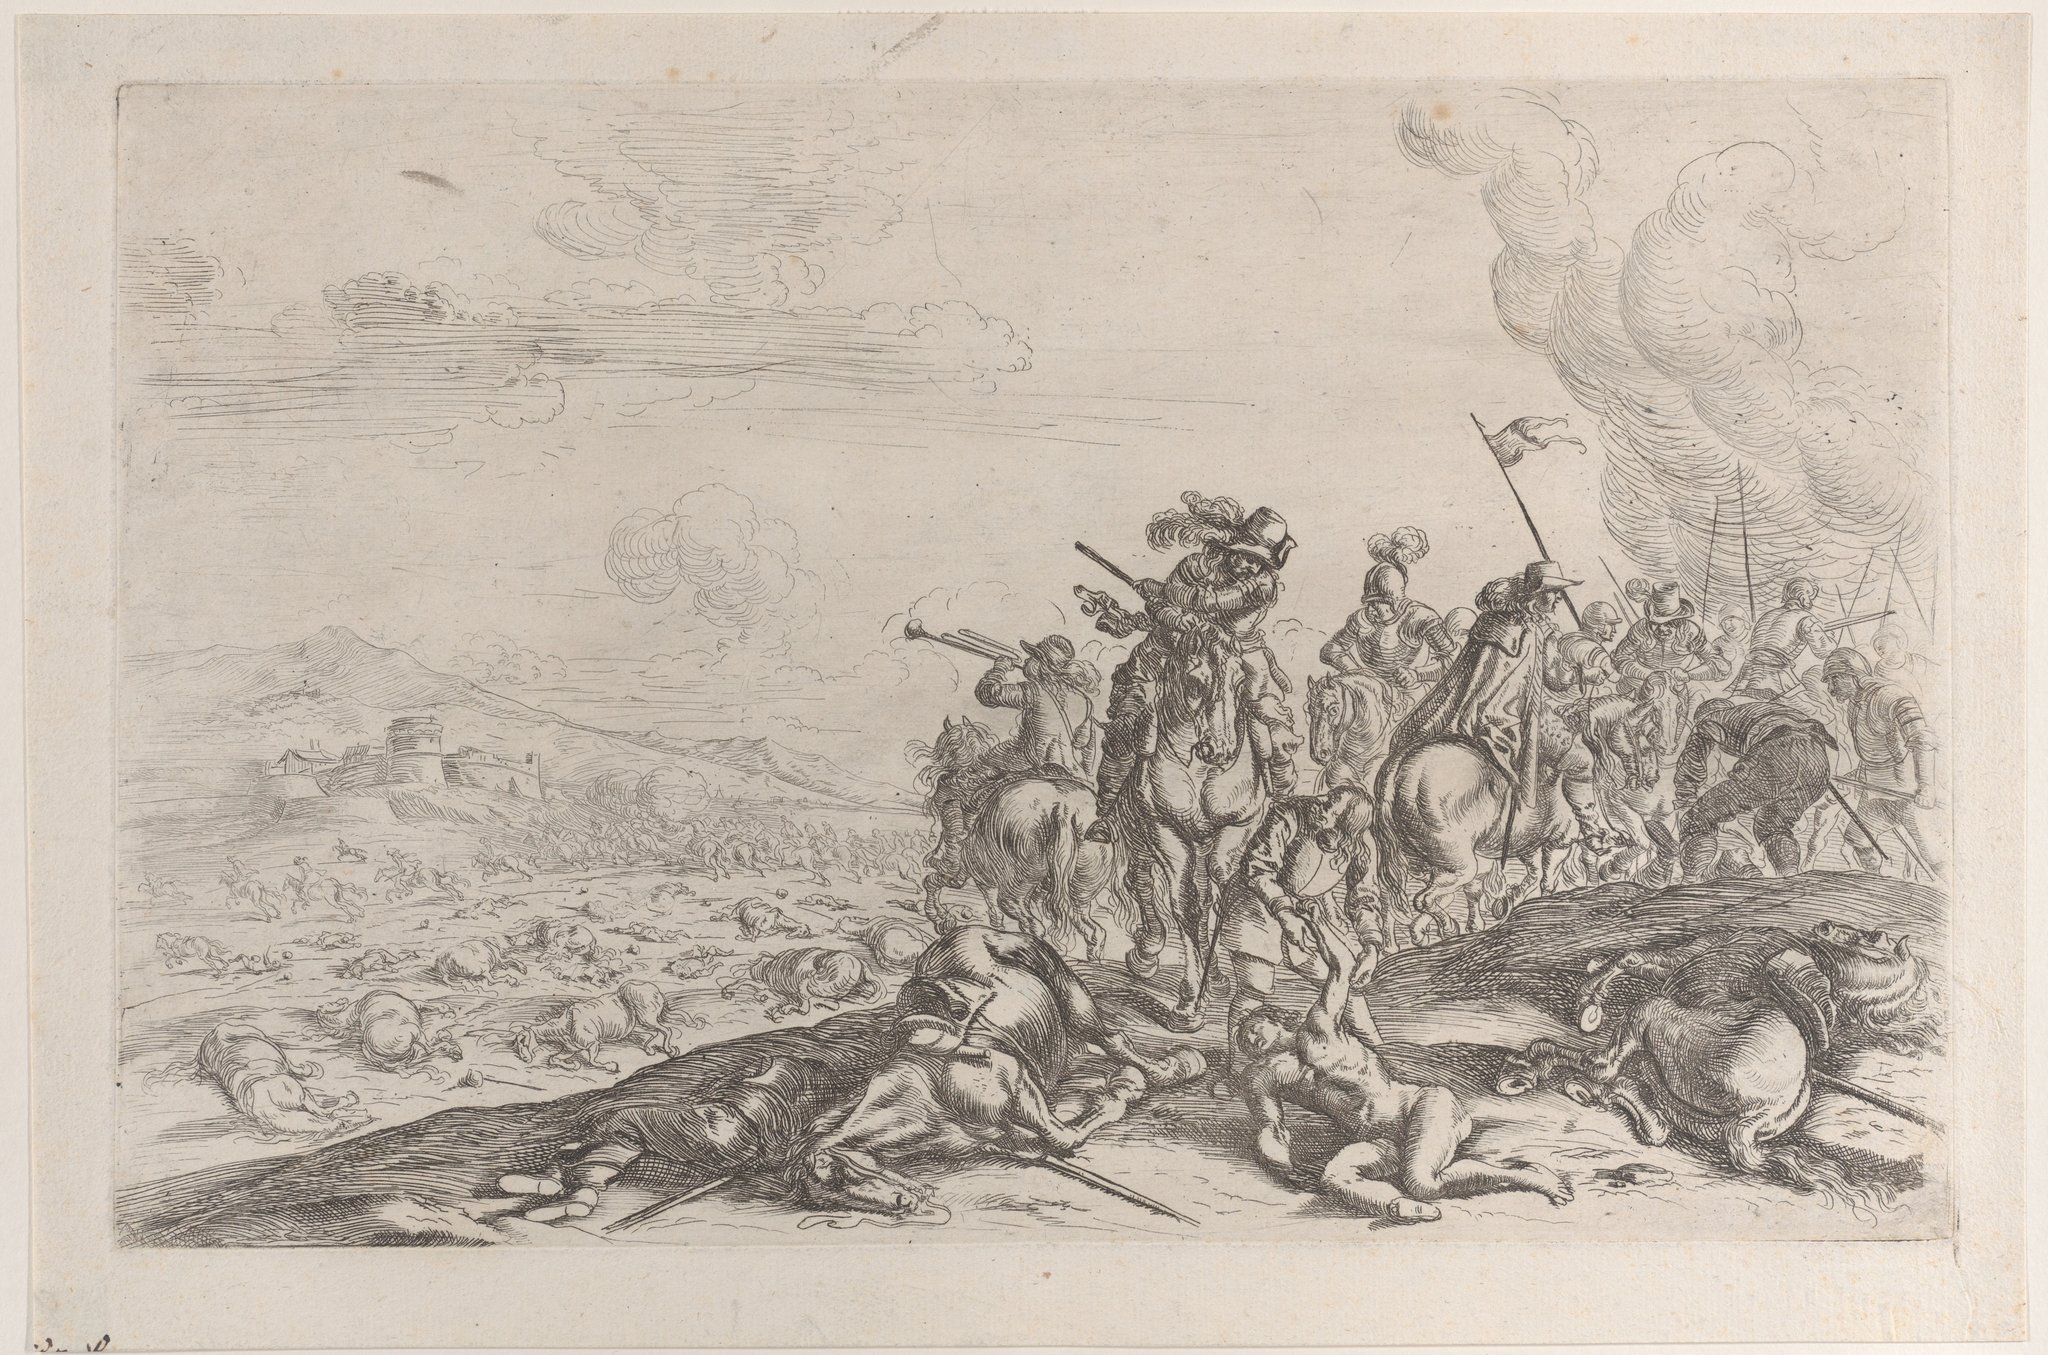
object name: print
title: Aiding the wounded after a battle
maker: jacques courtois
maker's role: artist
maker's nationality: french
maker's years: 1621-1676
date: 1635-1660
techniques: etching